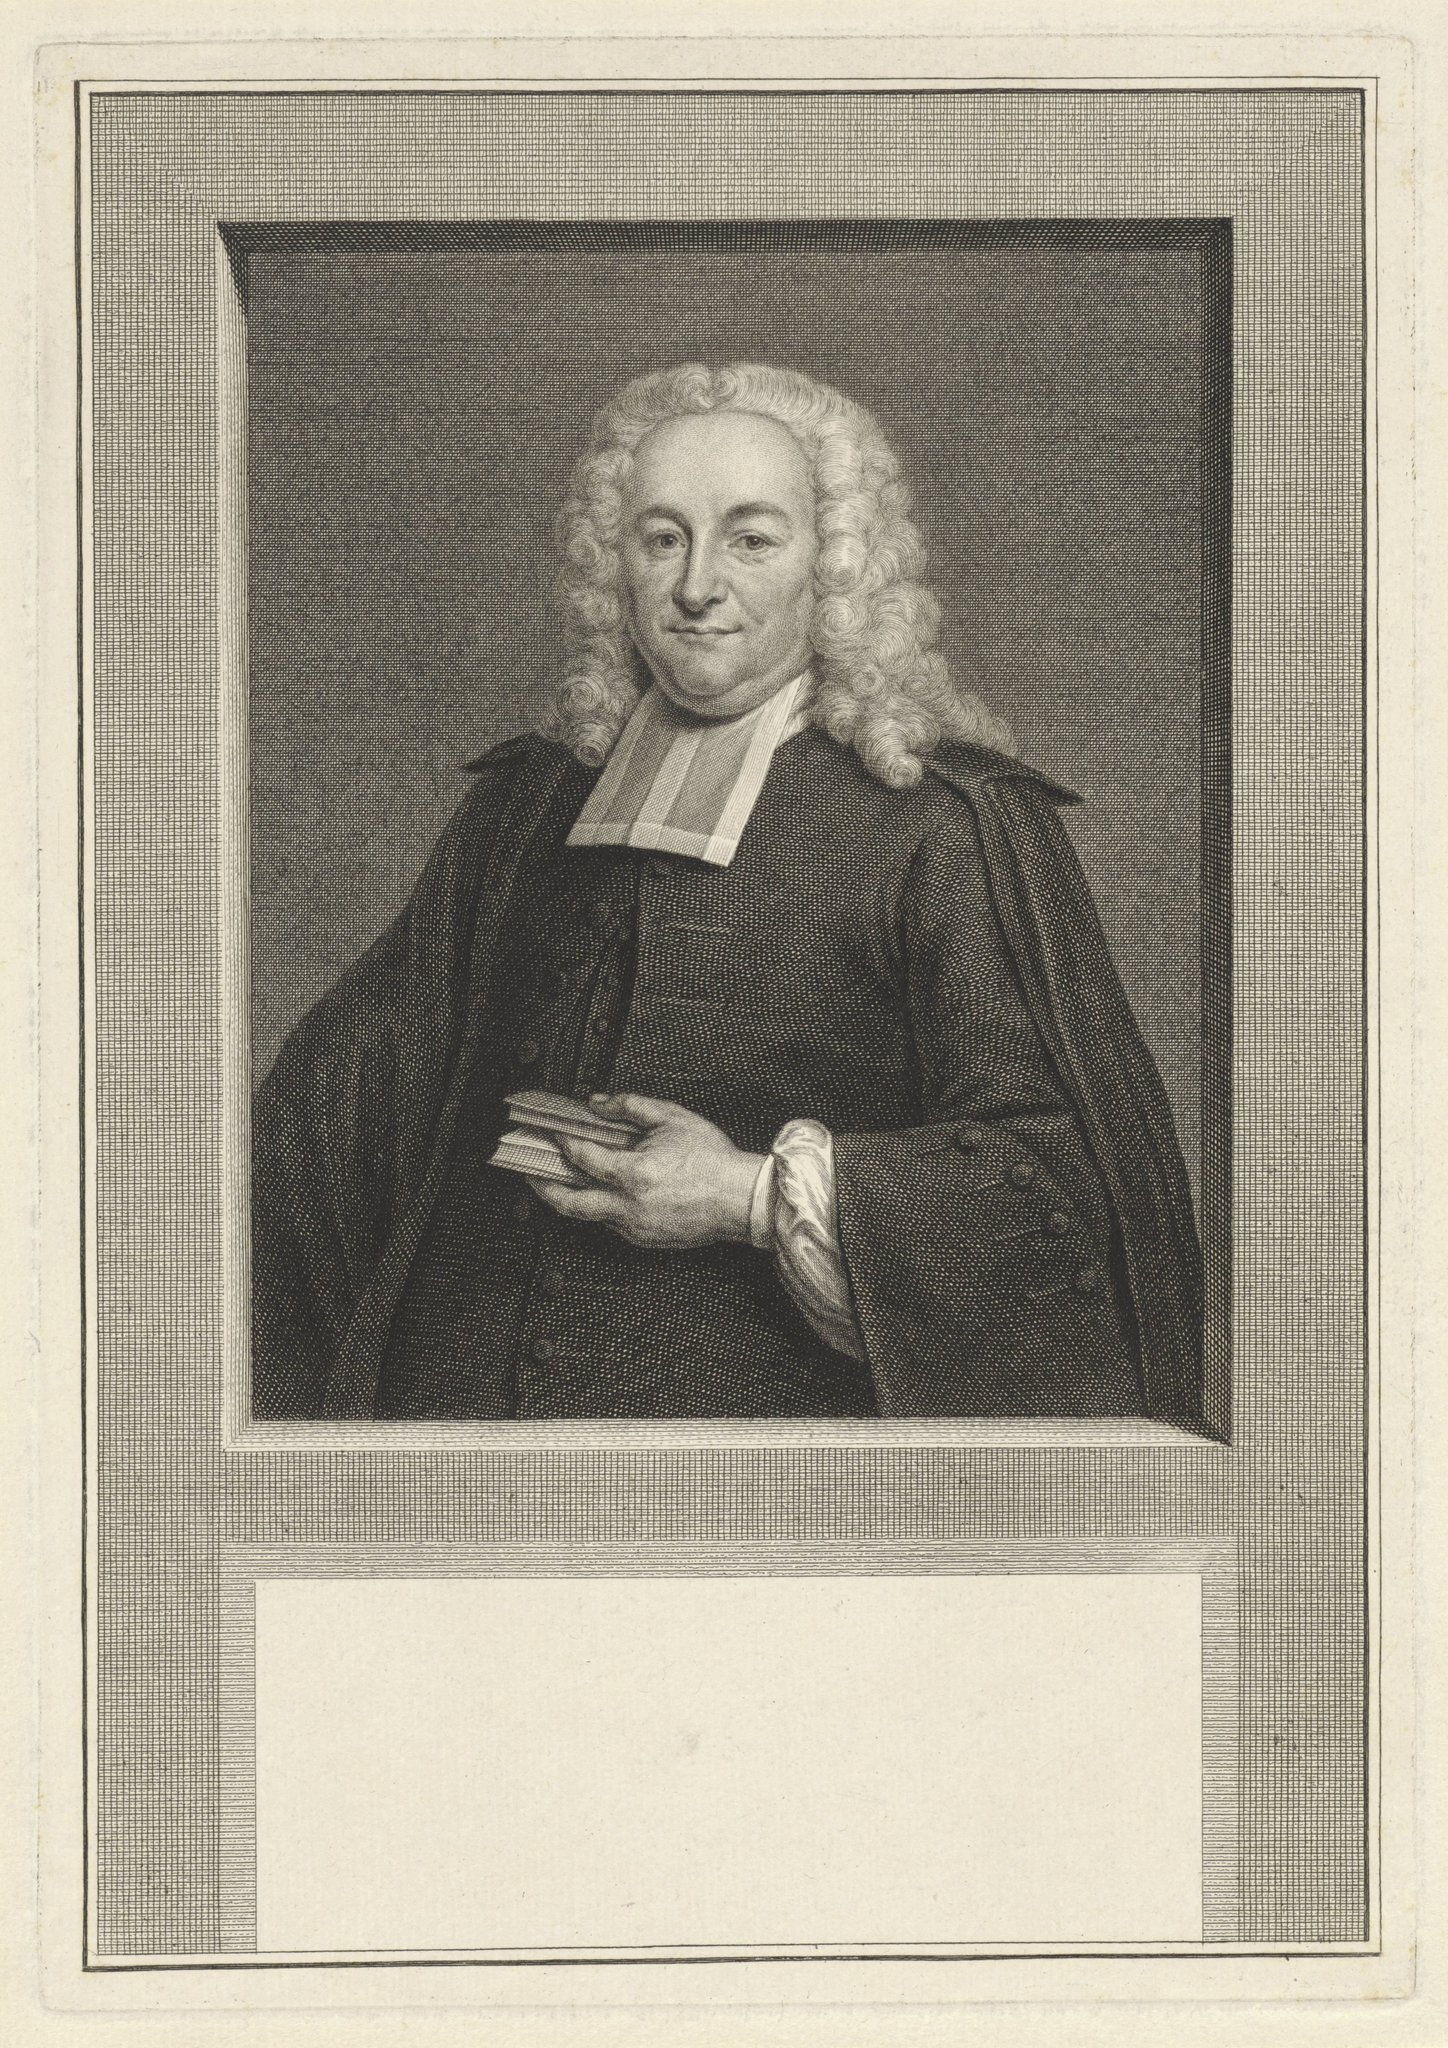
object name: print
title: Portret van Jacobus de Groot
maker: pieter tanjé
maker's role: draughtsman, print maker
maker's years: 1706-1761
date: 1750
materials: paper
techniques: engraving, etching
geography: amsterdam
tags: utrecht, the bible as a book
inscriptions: collector's mark: Lugt 240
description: Portret van Jacobus de Groot, predikant te Utrecht, met een bijbel in zijn hand.